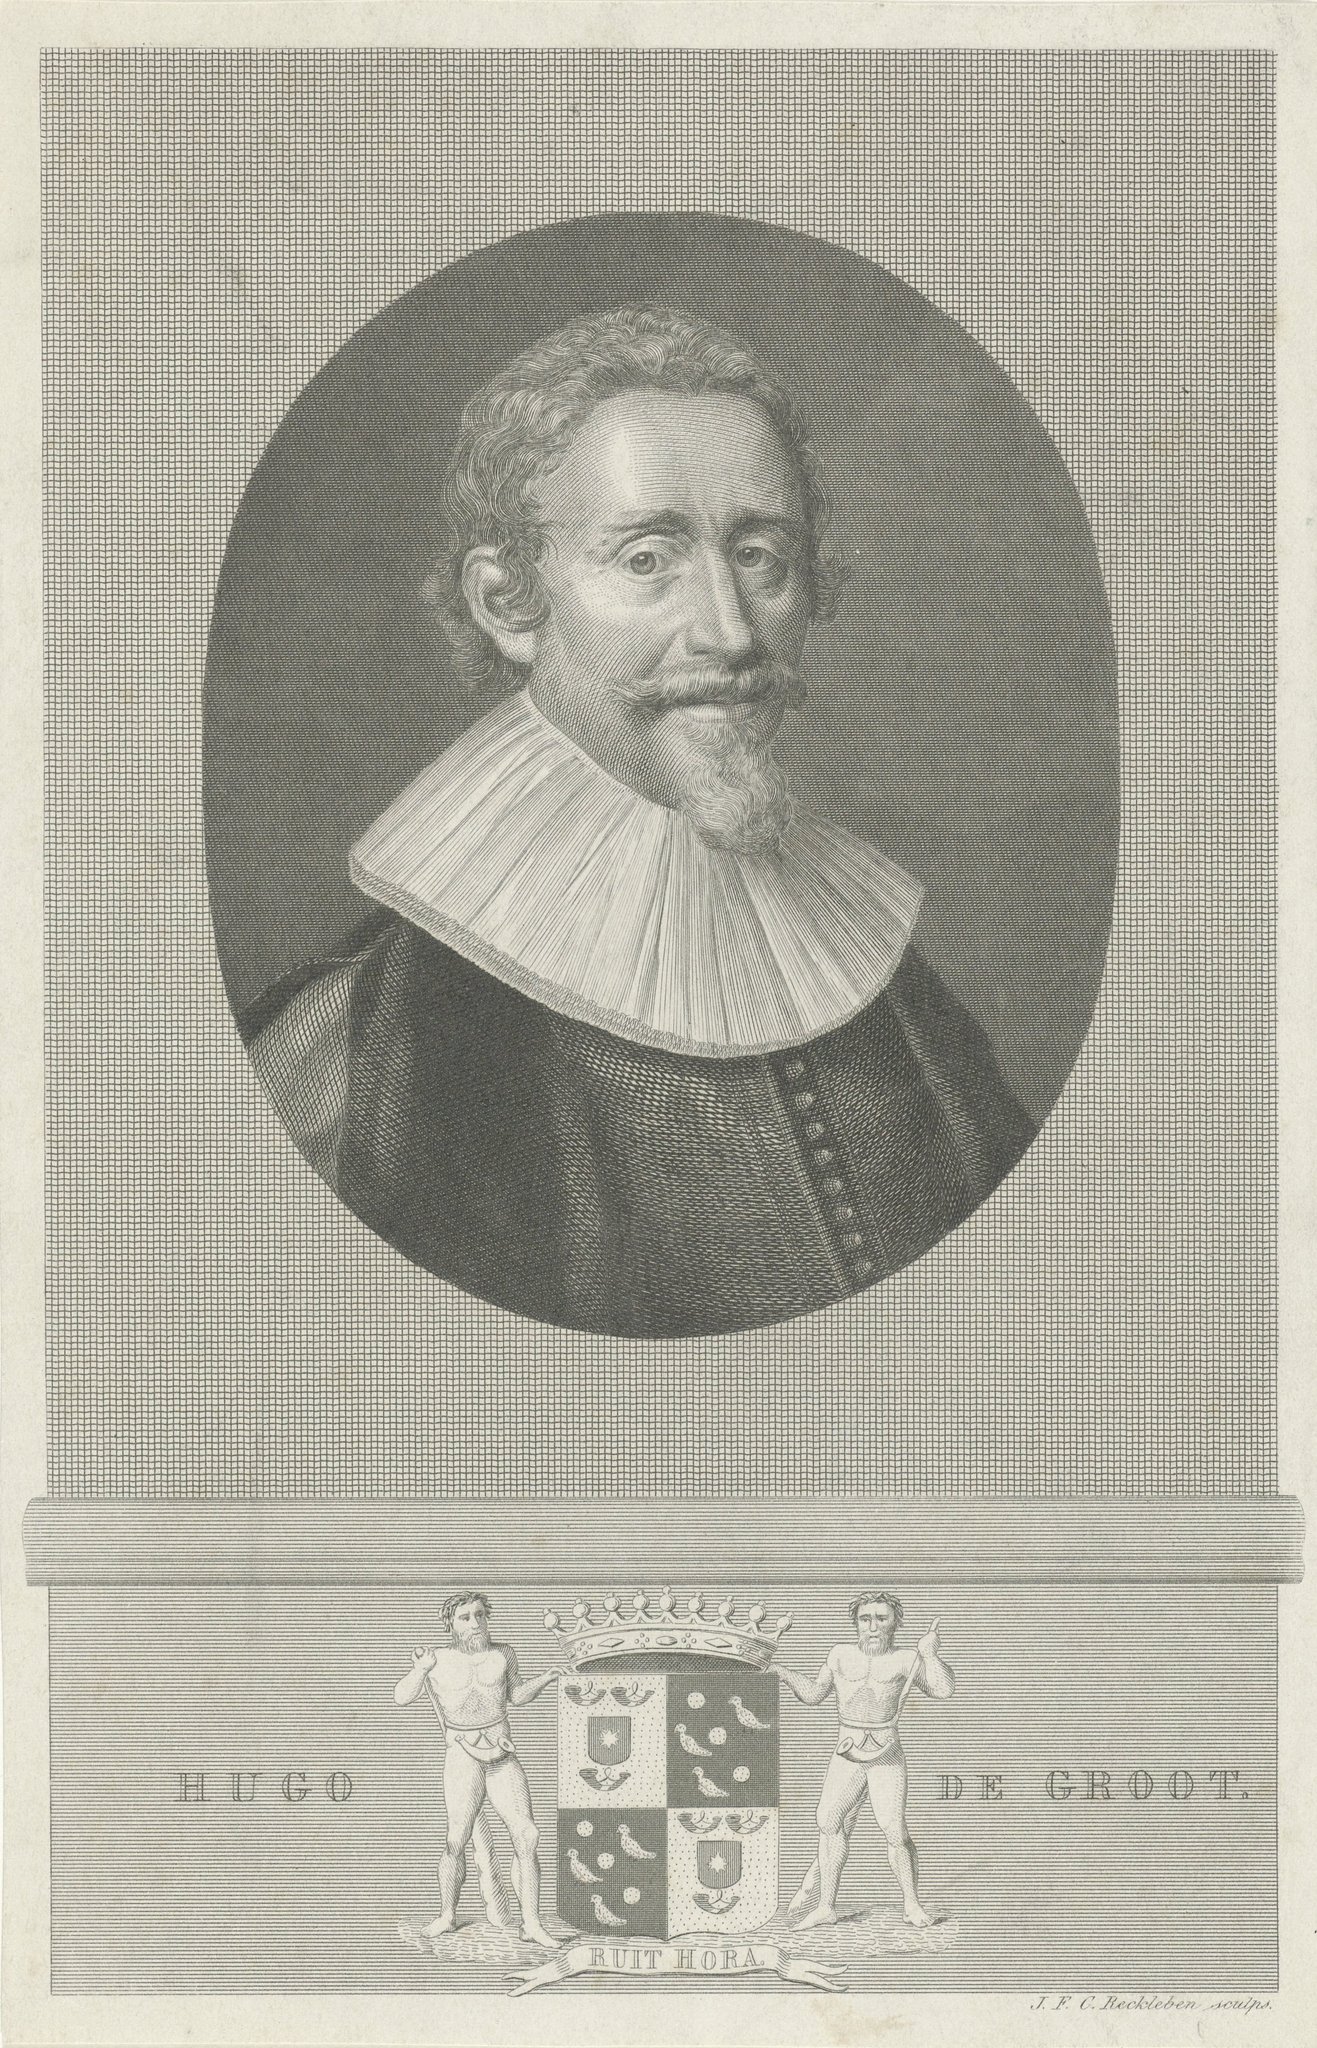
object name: print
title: Portret van Hugo de Groot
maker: jan frederik christiaan reckleben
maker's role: print maker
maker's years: 1819-1879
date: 1855-1857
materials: paper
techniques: engraving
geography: amsterdam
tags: delft, hugo de groot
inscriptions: collector's mark: Lugt 2228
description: Illustratie in: Arend, Johannes Pieter. Algemeene geschiedenis des vaderlands van de vroegste tijden tot op heden. 5 delen, Amsterdam: Schleijer, J.F. 1840-1884, dl. 3.2, p. 672.